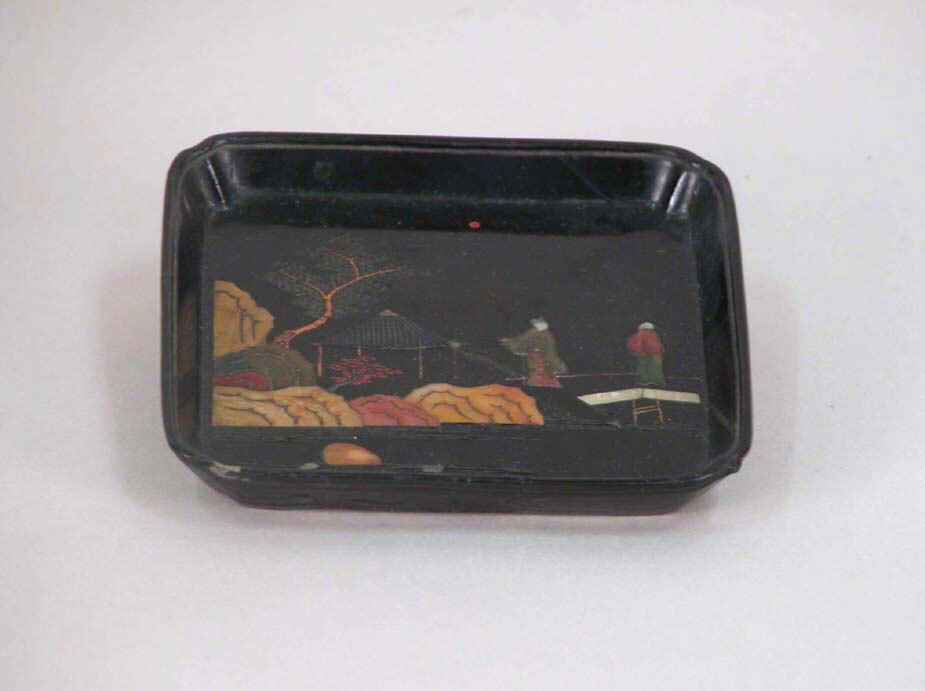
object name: tray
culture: chinese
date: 1601-1700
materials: lacquer